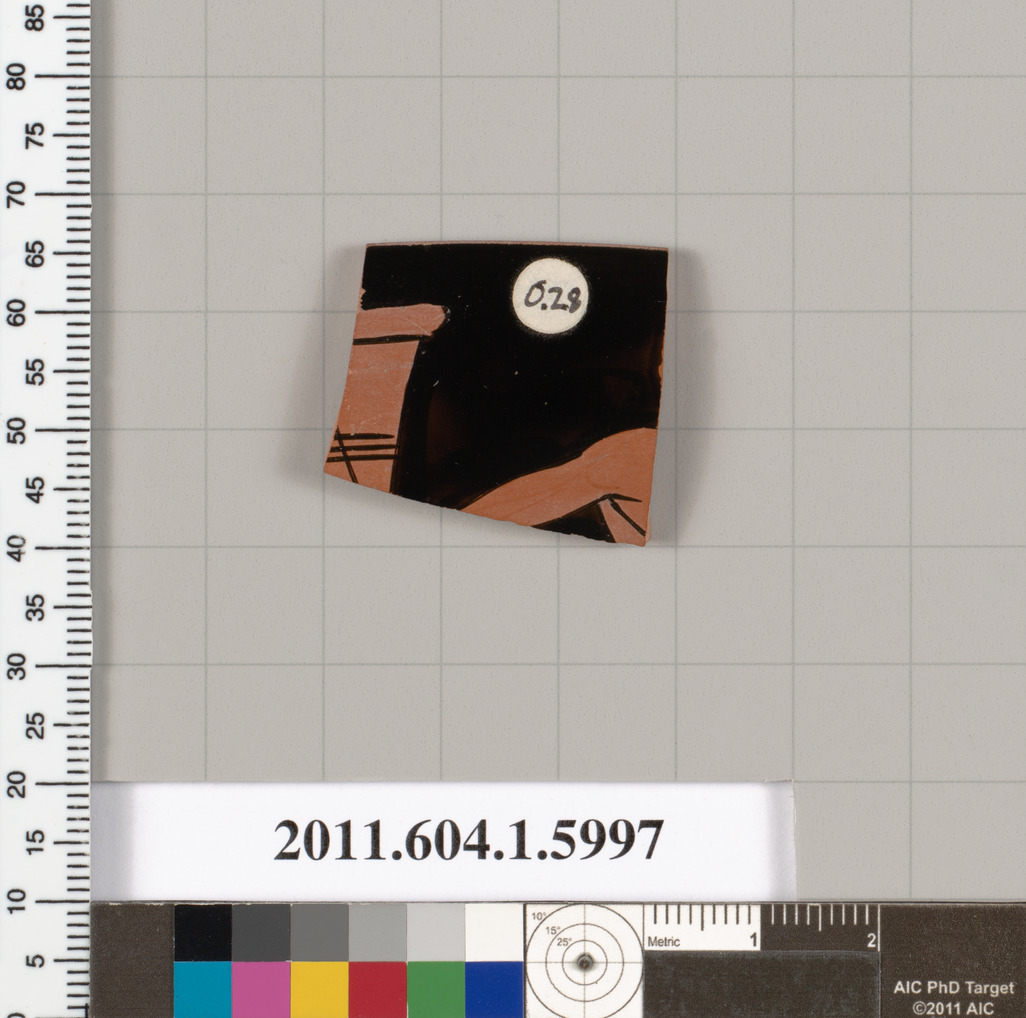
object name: kylix fragment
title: Terracotta rim fragment of a kylix (drinking cup)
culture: greek, attic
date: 510-500 BCE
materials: terracotta